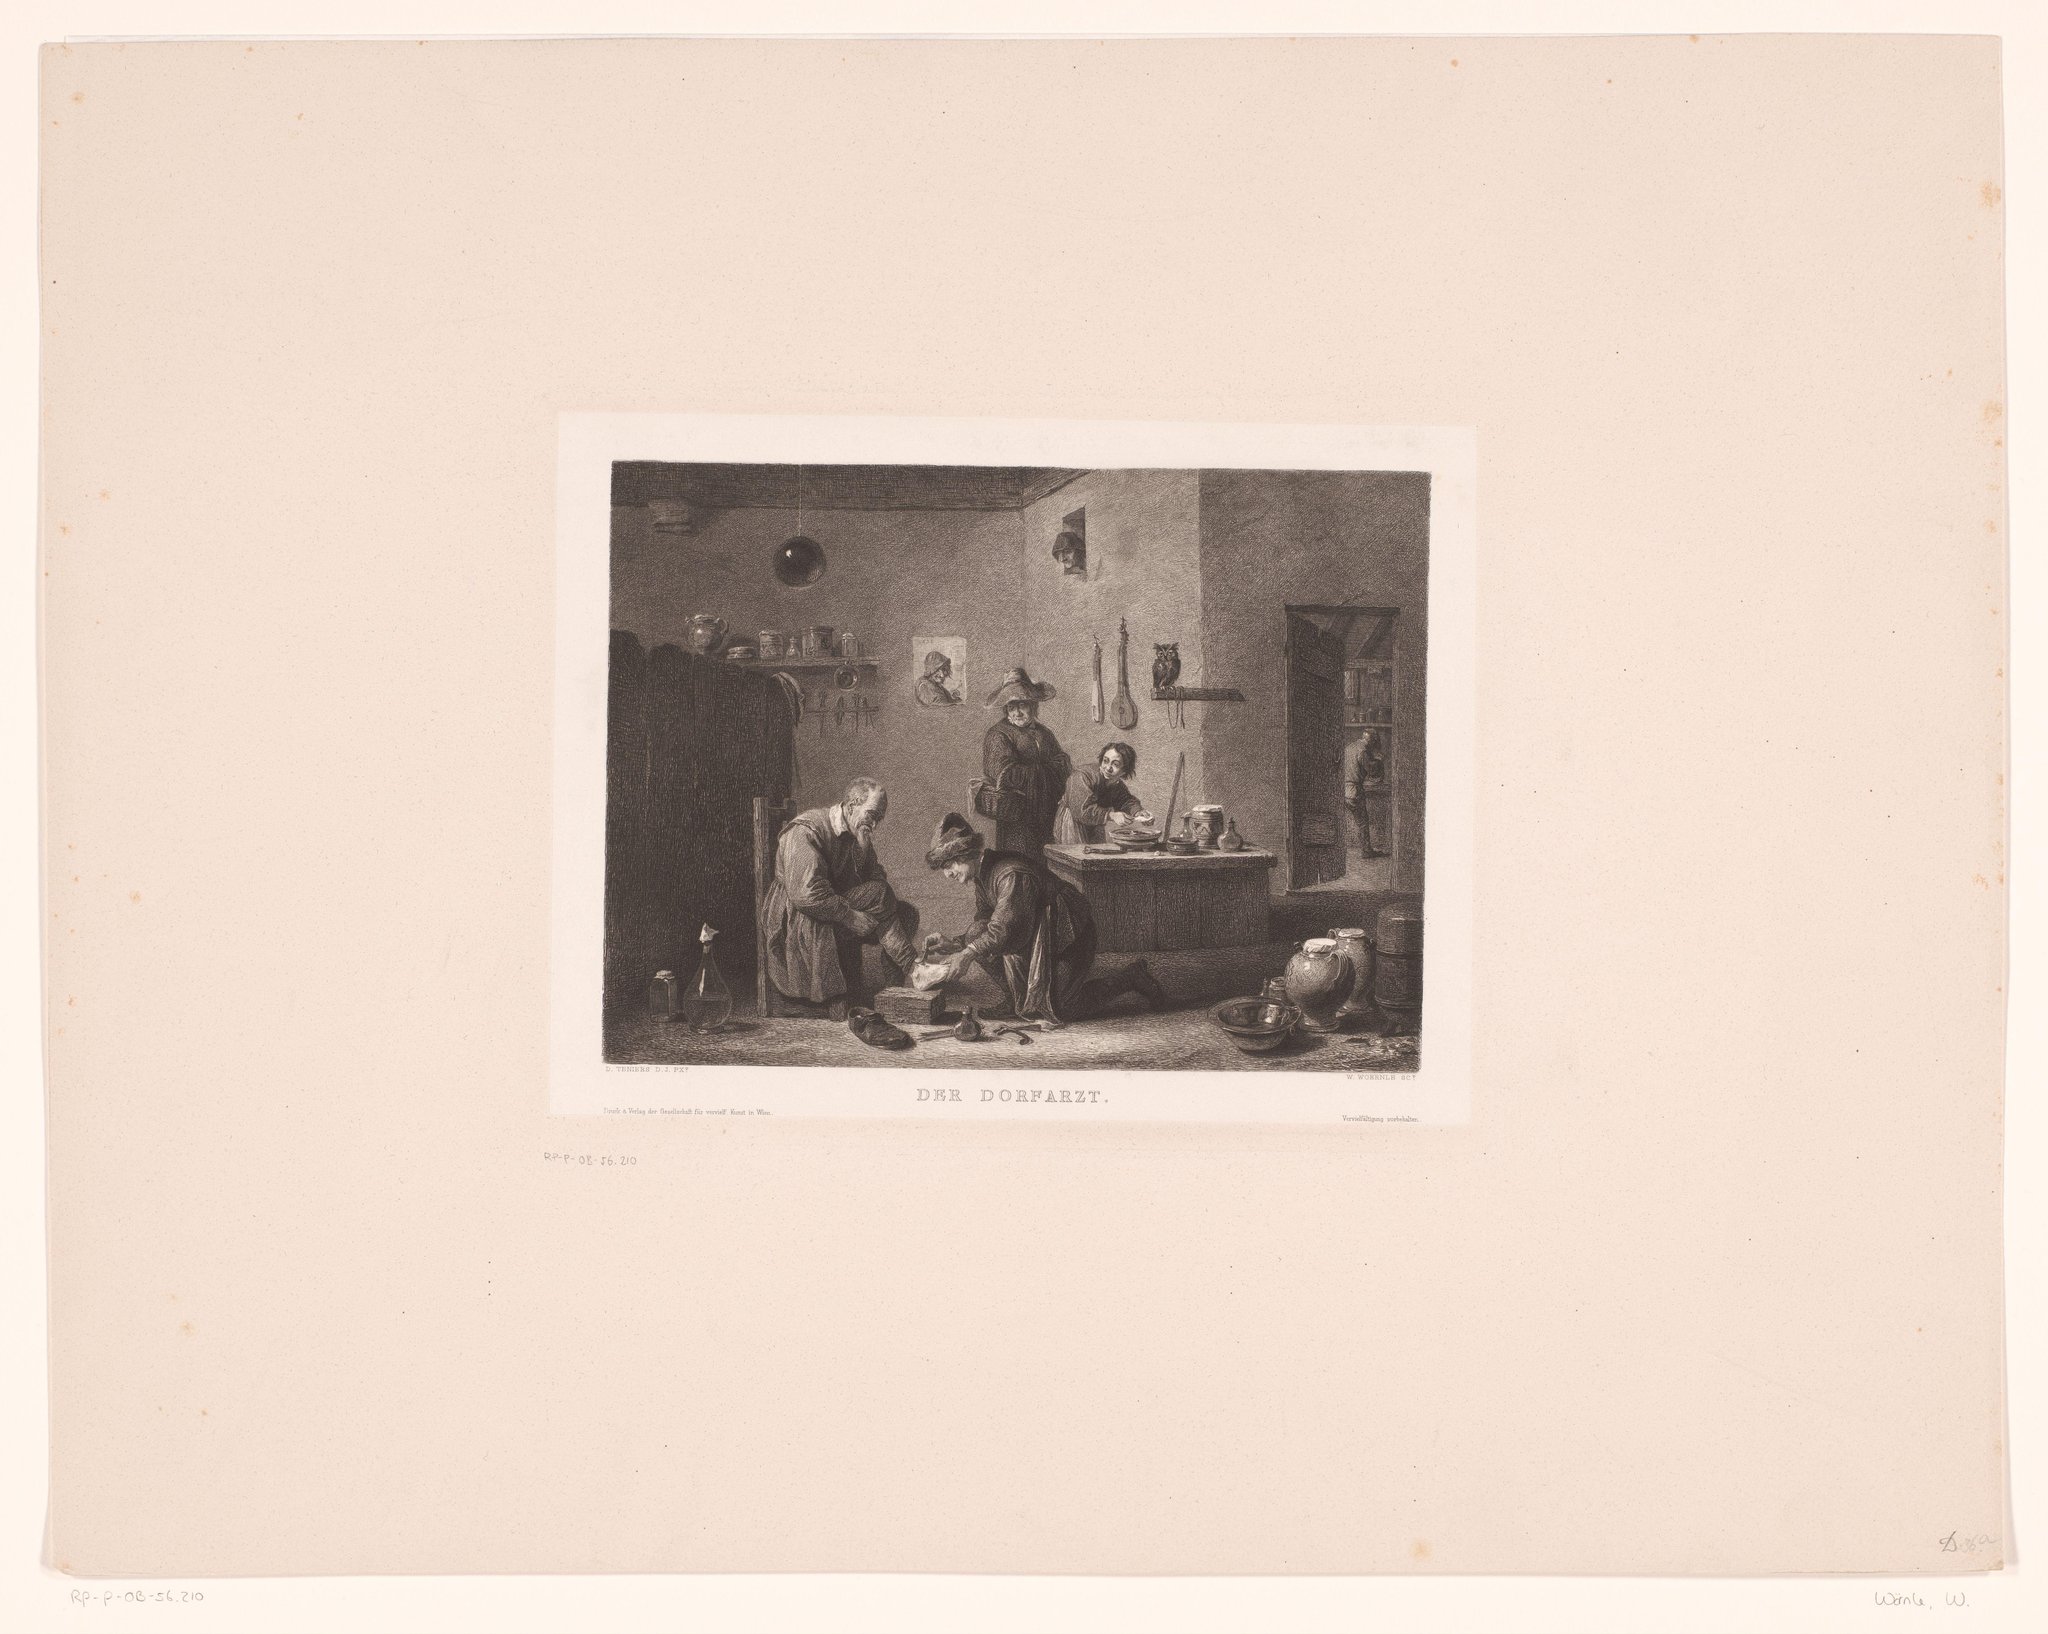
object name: print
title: Dorpsdokter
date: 1859-1916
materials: paper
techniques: etching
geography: vienna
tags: print, e.g.: engraving, etching, lithograph, physician, doctor, owls, string instruments (plucked)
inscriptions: collector's mark: Lugt 2228